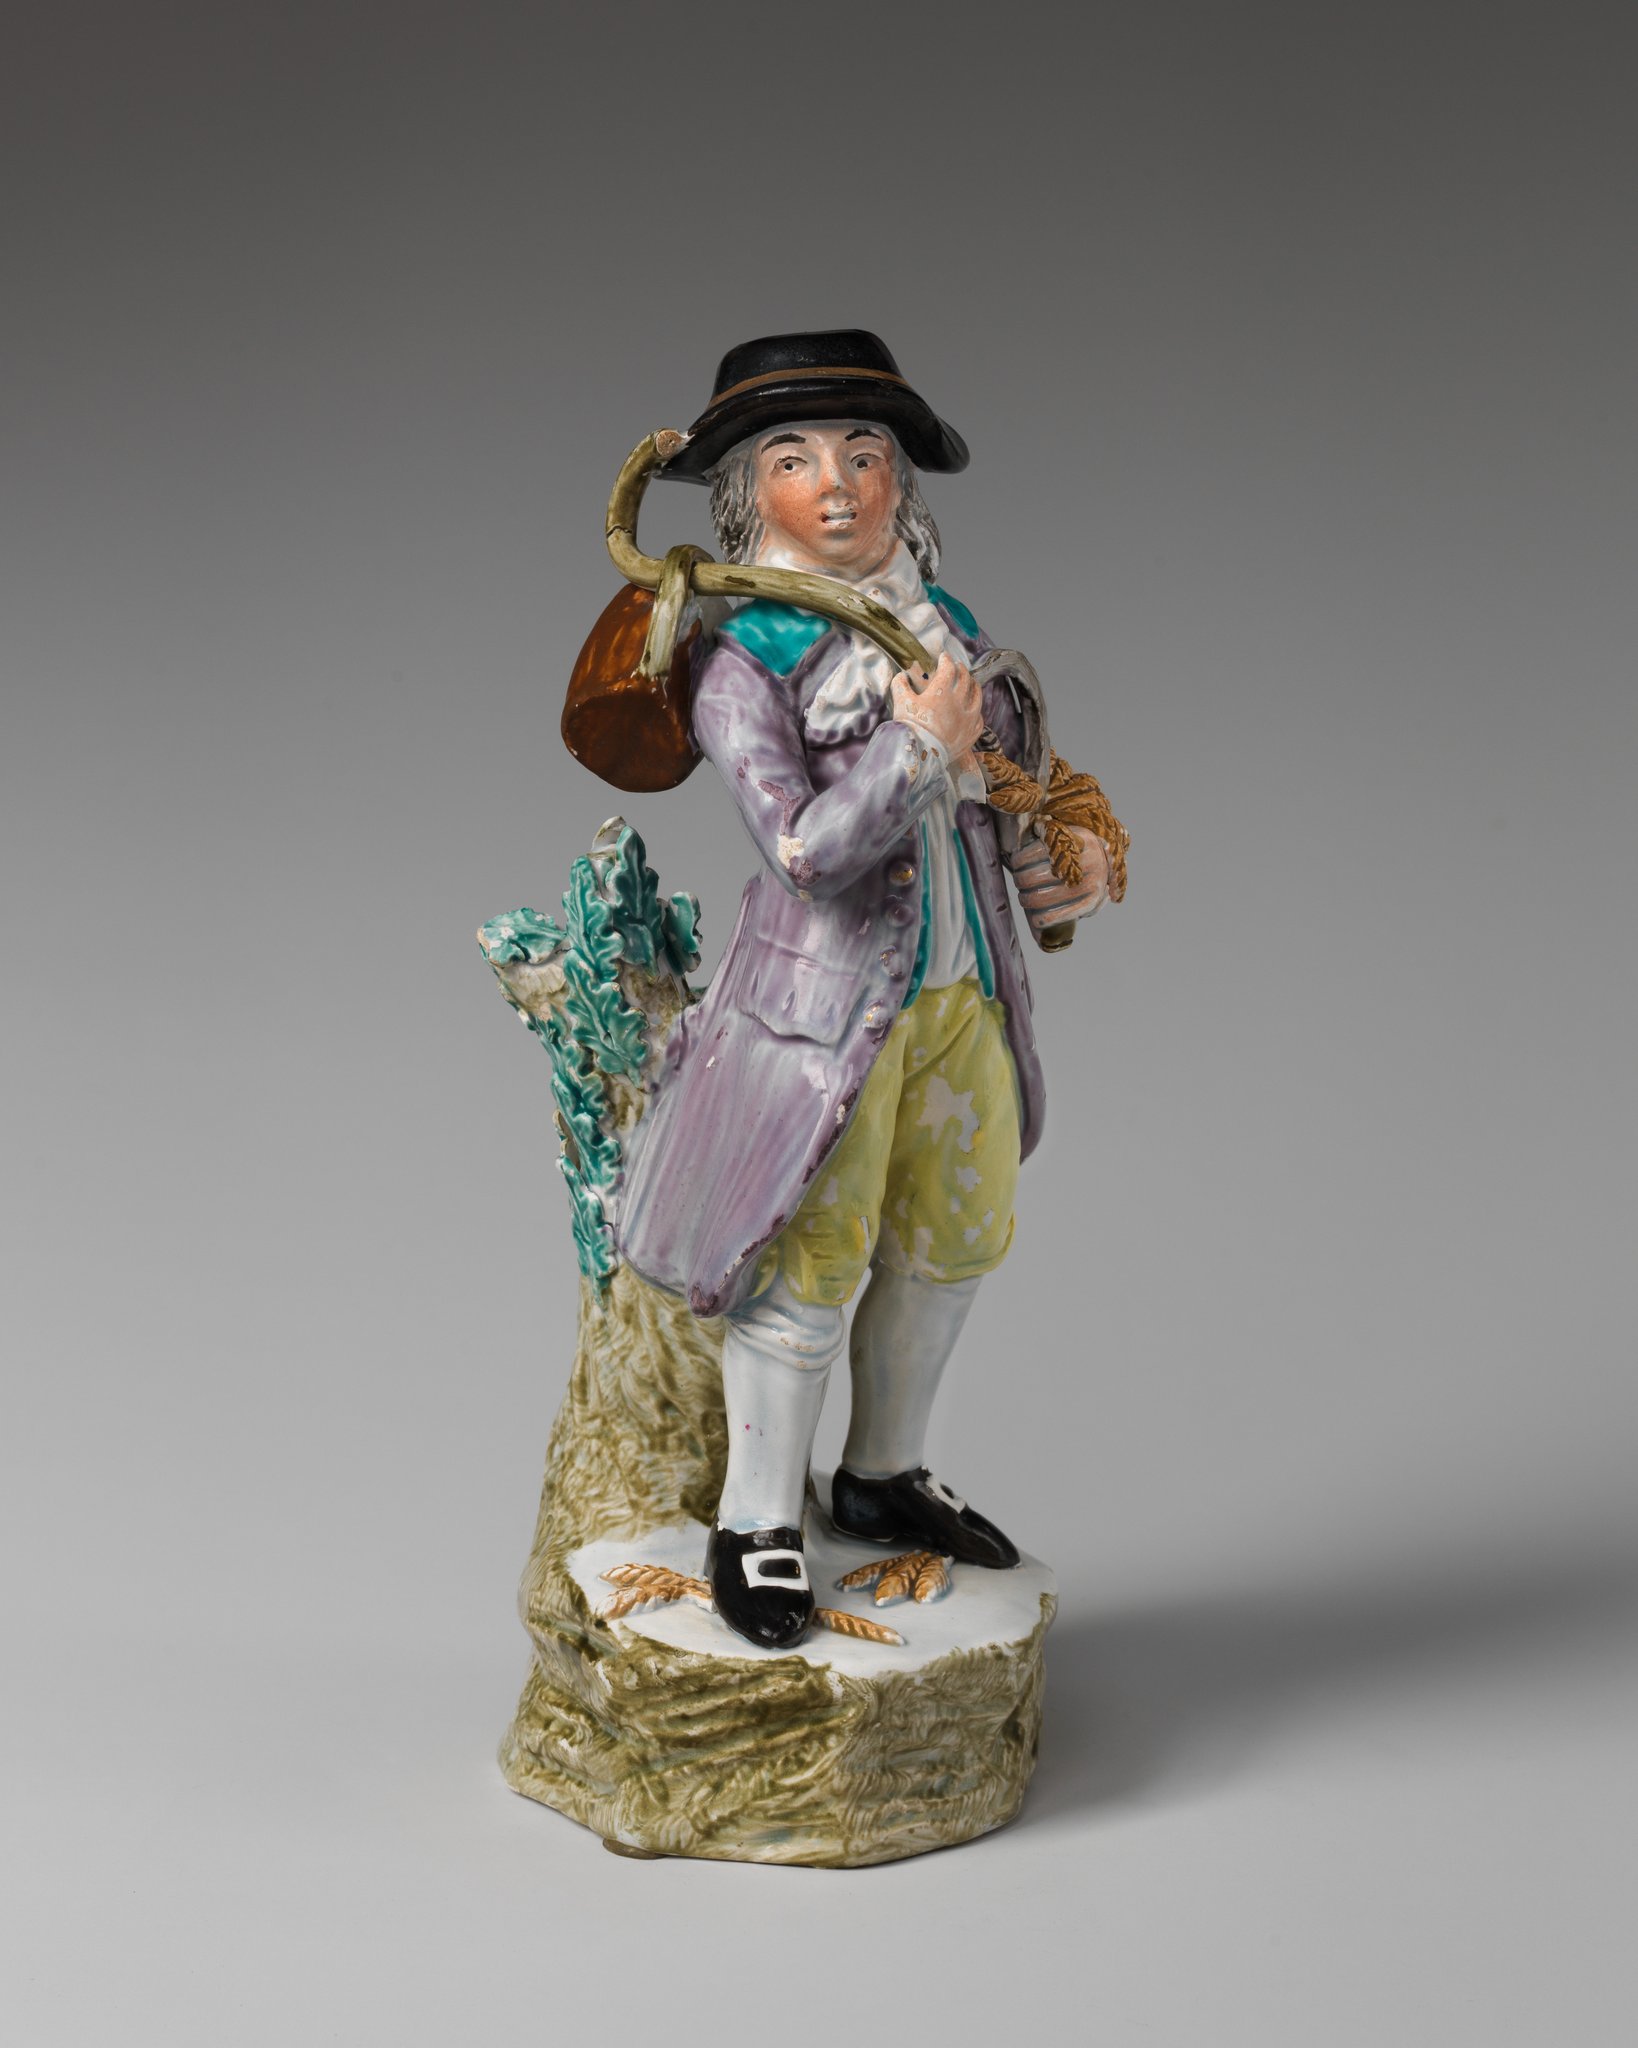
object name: figure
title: Harvester and woman companion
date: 1790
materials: earthenware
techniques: glazing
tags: men,leaves